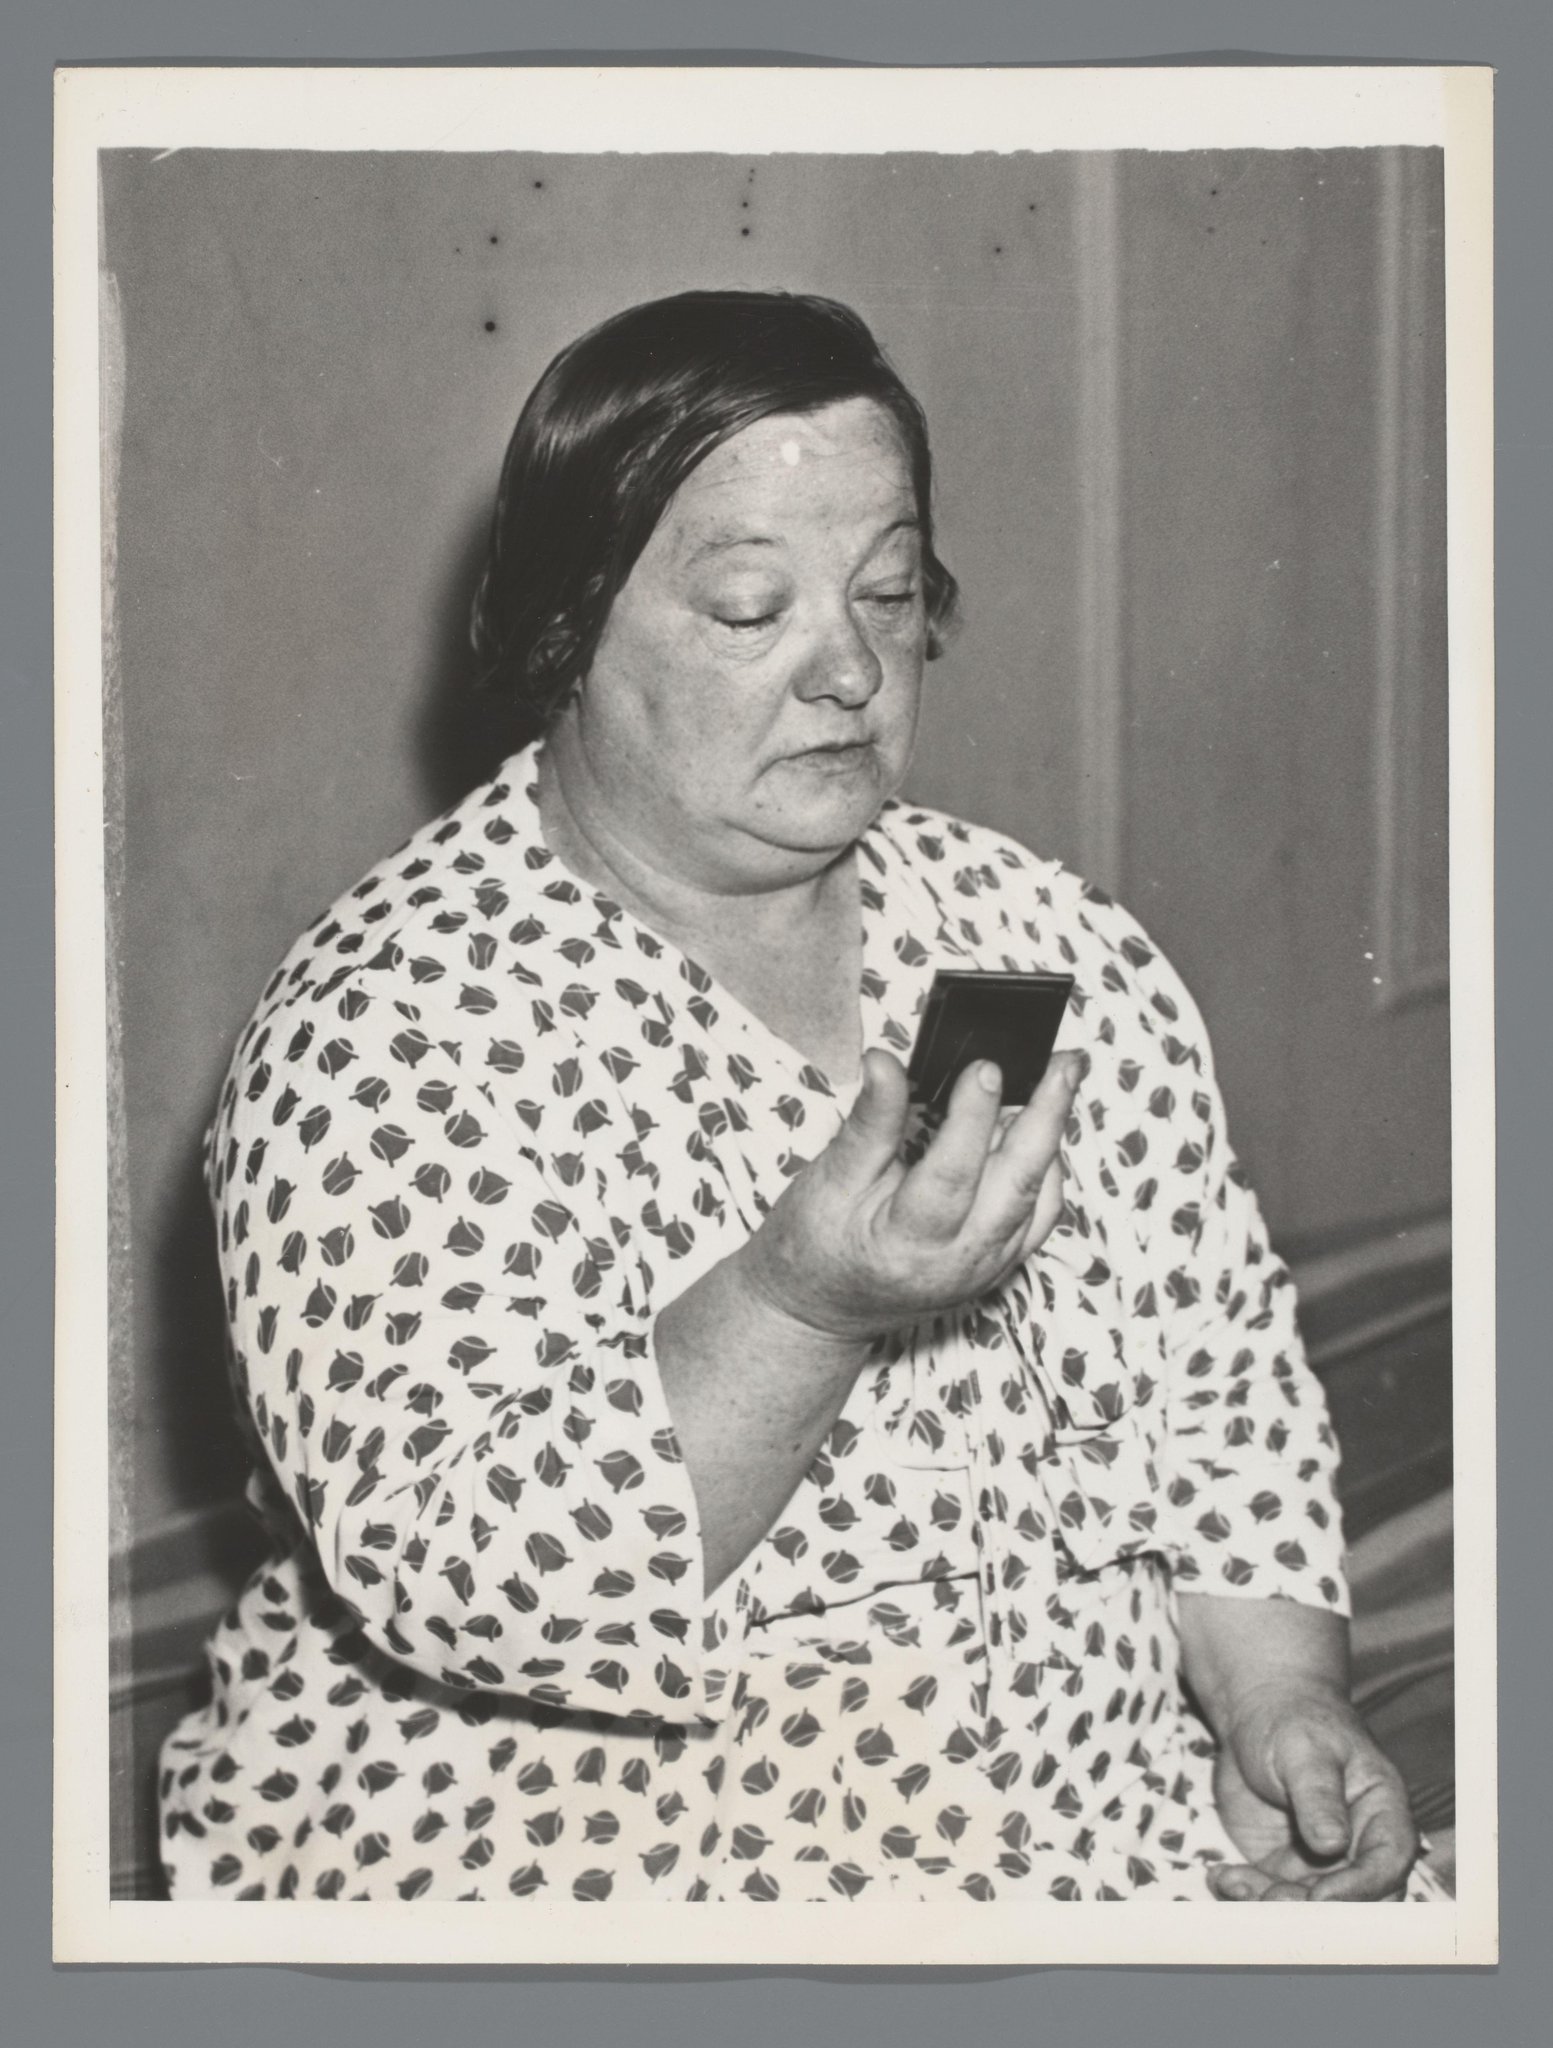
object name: photograph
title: Portret van een onbekende vrouw, aangeduid als de echtgenote van Lawrence Marks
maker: Anonymous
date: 1937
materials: paper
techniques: gelatin silver print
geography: united states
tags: anonymous historical person portrayed - bb - woman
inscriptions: inscription: ‘405238 HER HUSBAND CONFESSES TO MURDER OF CHILD Mrs. Lawrence Marks, whose husband, a 49-year-old ex-convict, confessed, august 8th, that he was the murderer of 8-year-old Paula Magagna in Brooklyn, N.Y., July 31st. Marks has been out on parole since June, and has a long series of sex offenses on his records. CREDIT LINE (ACME) 8/8/37 Full’, inscription: ‘REF. DEPT./ 8-12 37/ N.E.A.’, number: ‘17 43328’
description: Lawrence Marks vermoordde de 8-jarige Paula Magagna.